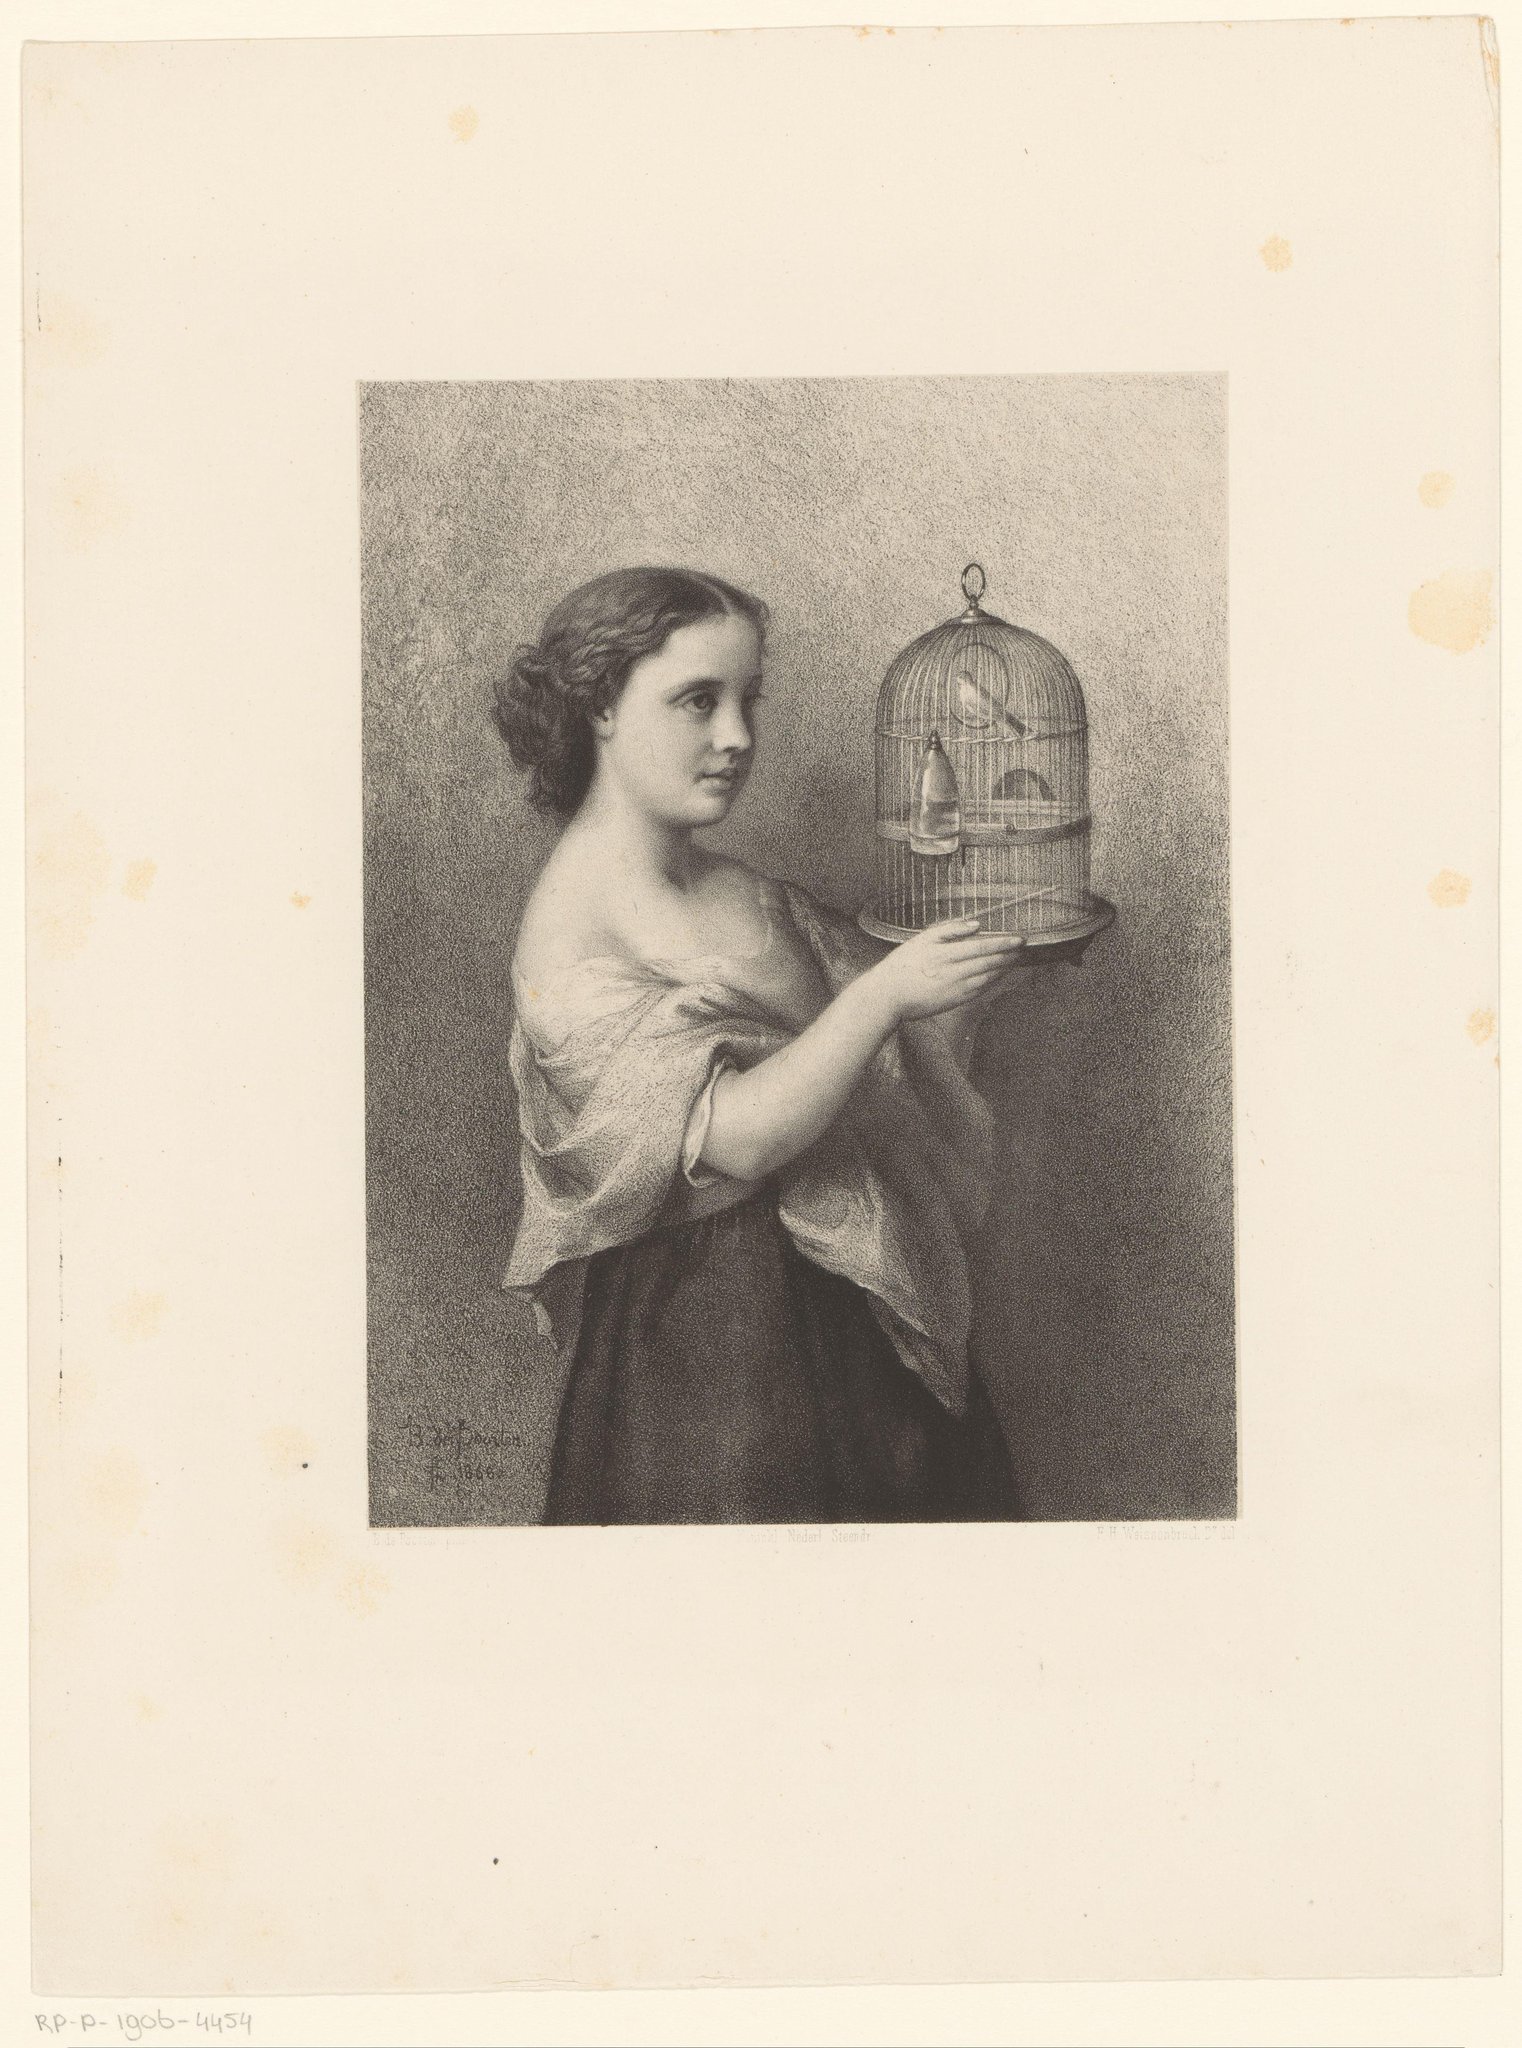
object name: print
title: Meisje met vogelkooi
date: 1868-1874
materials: paper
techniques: lithograph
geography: the hague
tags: girl (child between toddler and youth), bird in a cage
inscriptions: collector's mark: Lugt 2228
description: Een meisje kijkt naar de vogel in de kooi die zij in haar handen houdt.